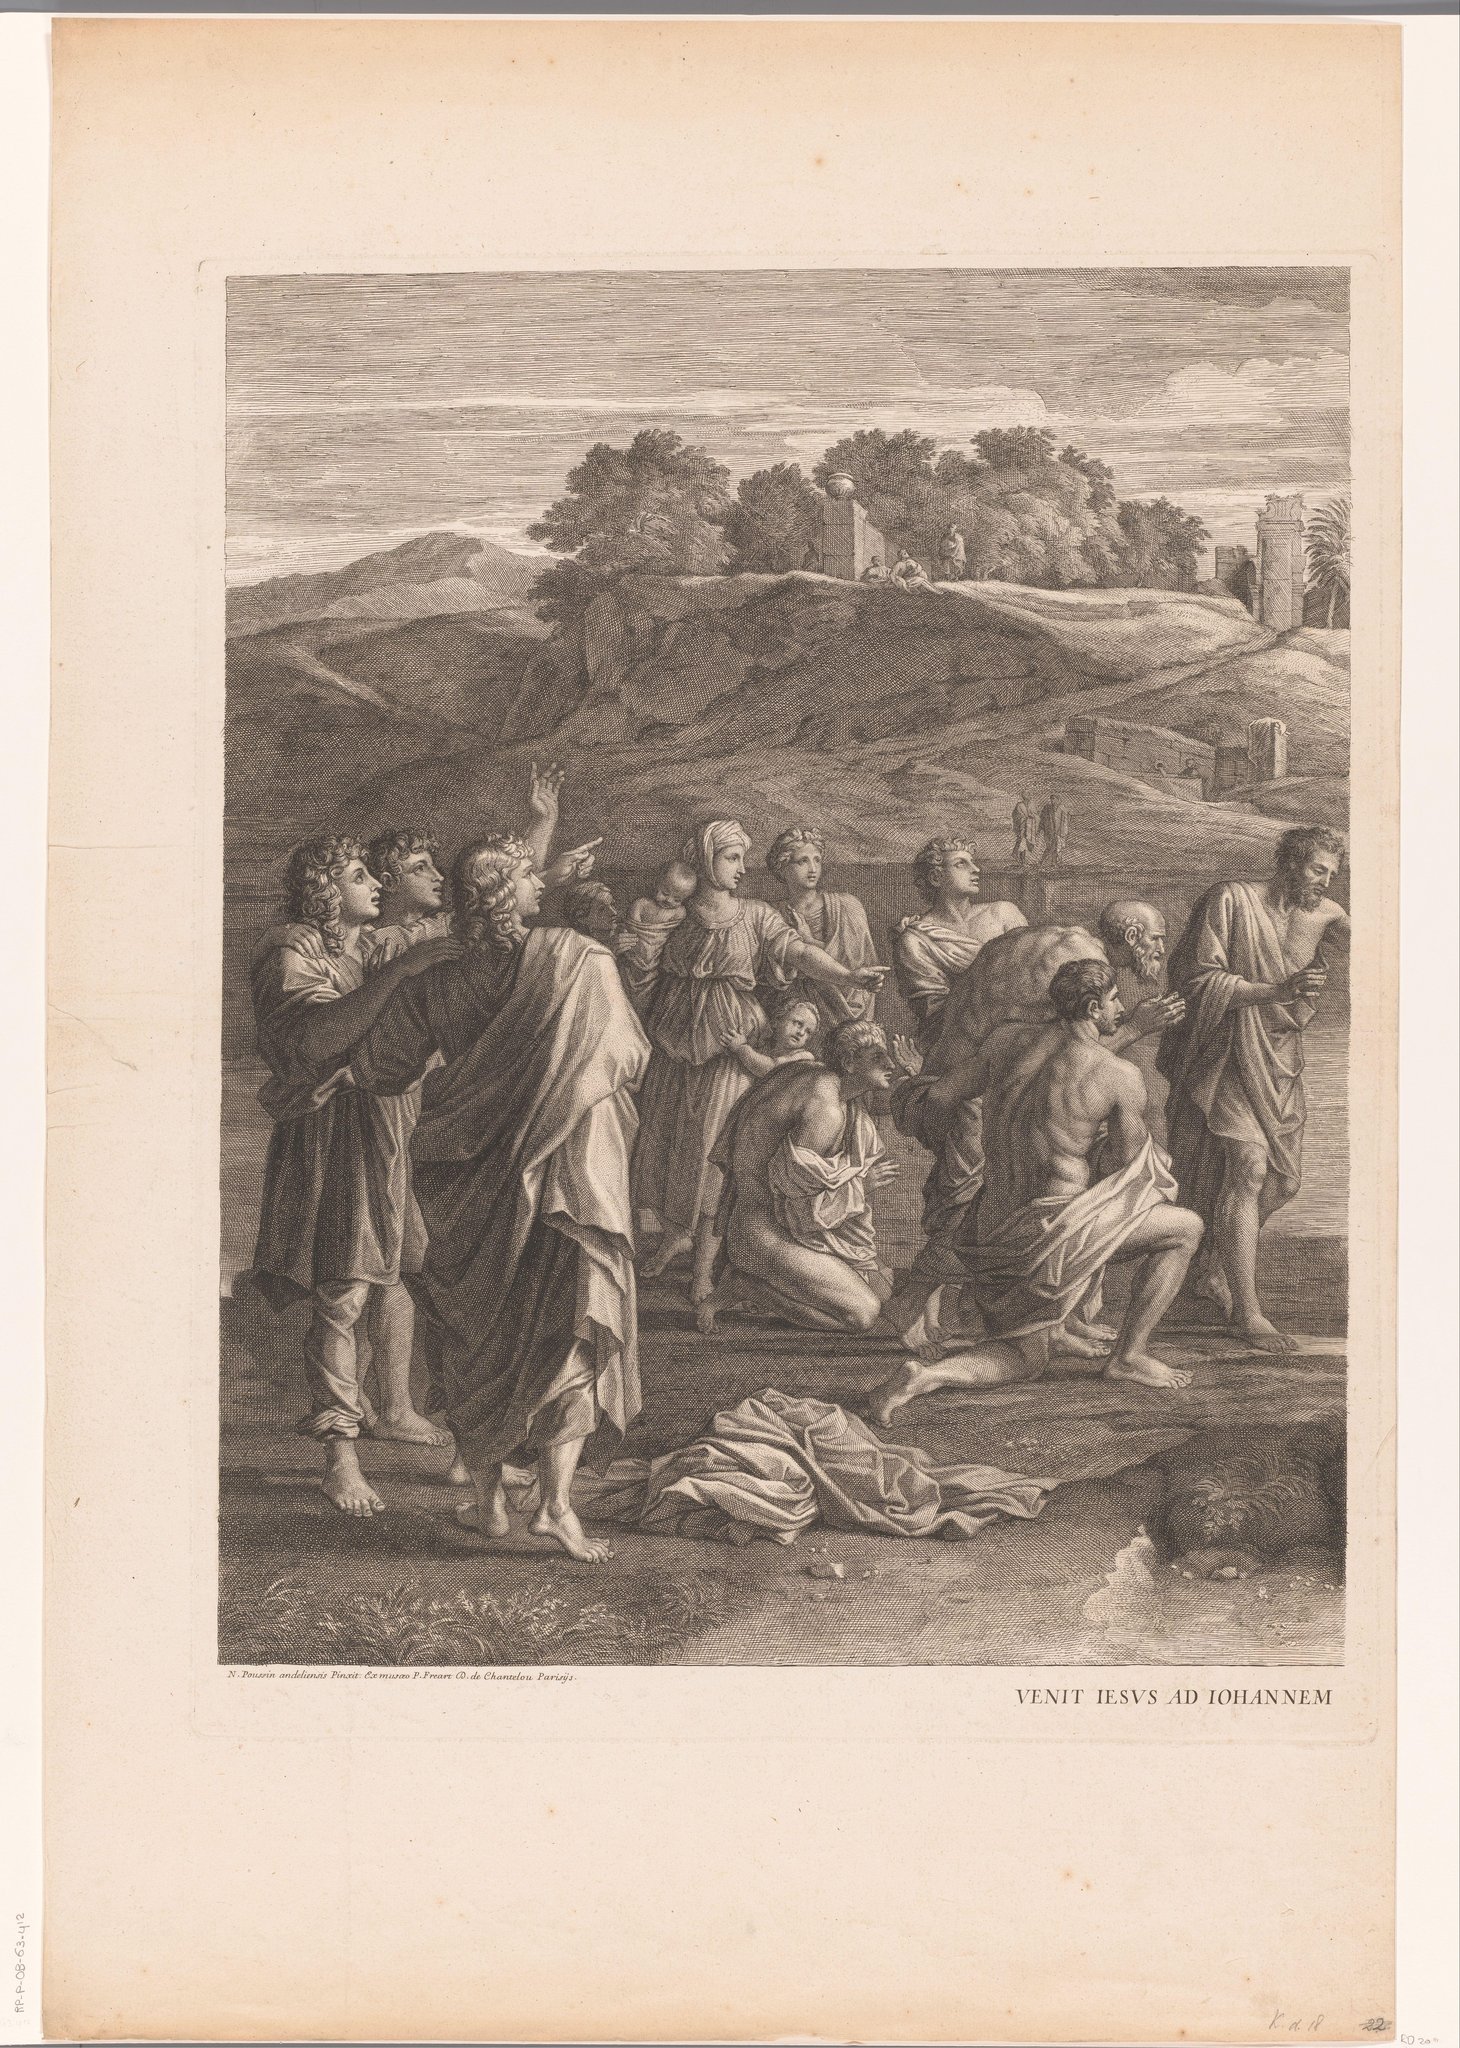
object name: print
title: Venit Iesus ad Iohannem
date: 1680-1694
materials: paper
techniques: etching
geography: france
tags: baptism of christ in the river jordan: john the baptist pouring out water on christ's head: the holy ghost descends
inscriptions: collector's mark: Lugt 240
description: Prent maakt deel uit van een ongenummerde serie van zeven prenten.